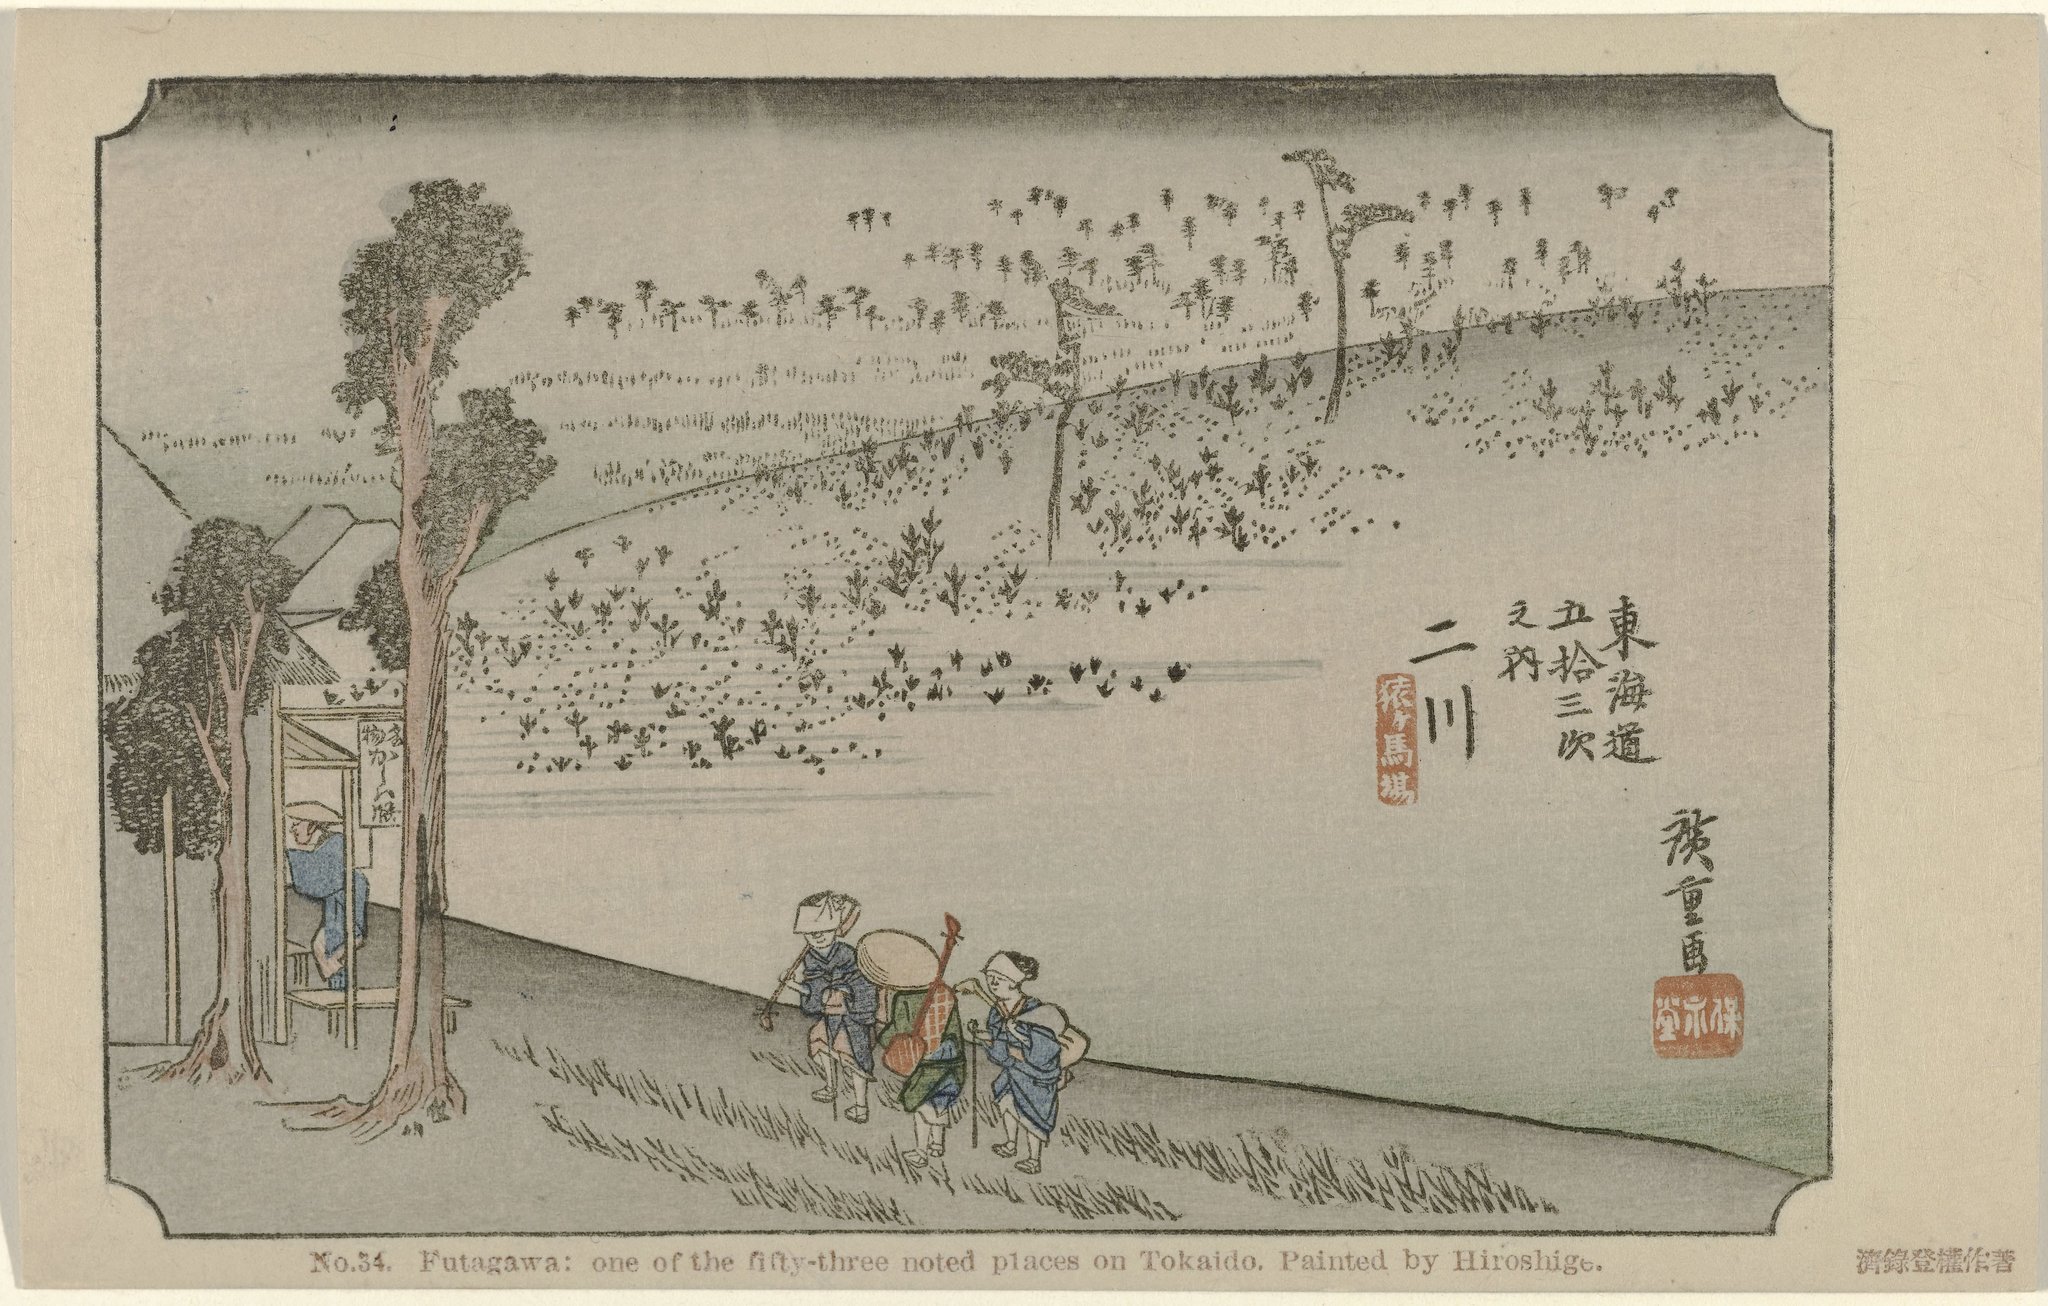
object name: ansichtkaart, prentbriefkaart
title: De Tôkaidô van Hiroshige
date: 1906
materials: cardboard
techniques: woodcut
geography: japan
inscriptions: date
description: Reizgers lopen richting een theehuisje bij Futugawa.